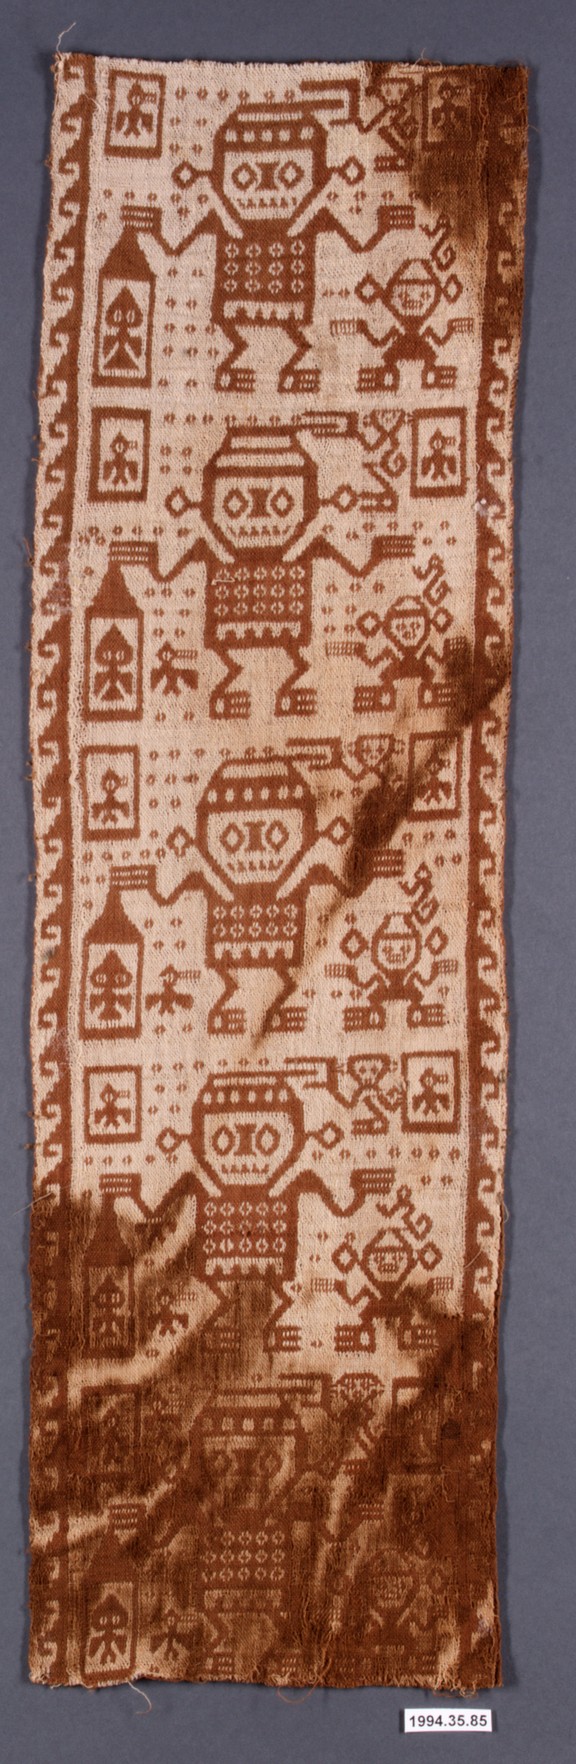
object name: sash fragment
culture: peruvian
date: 1301-1533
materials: cotton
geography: peru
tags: human figures